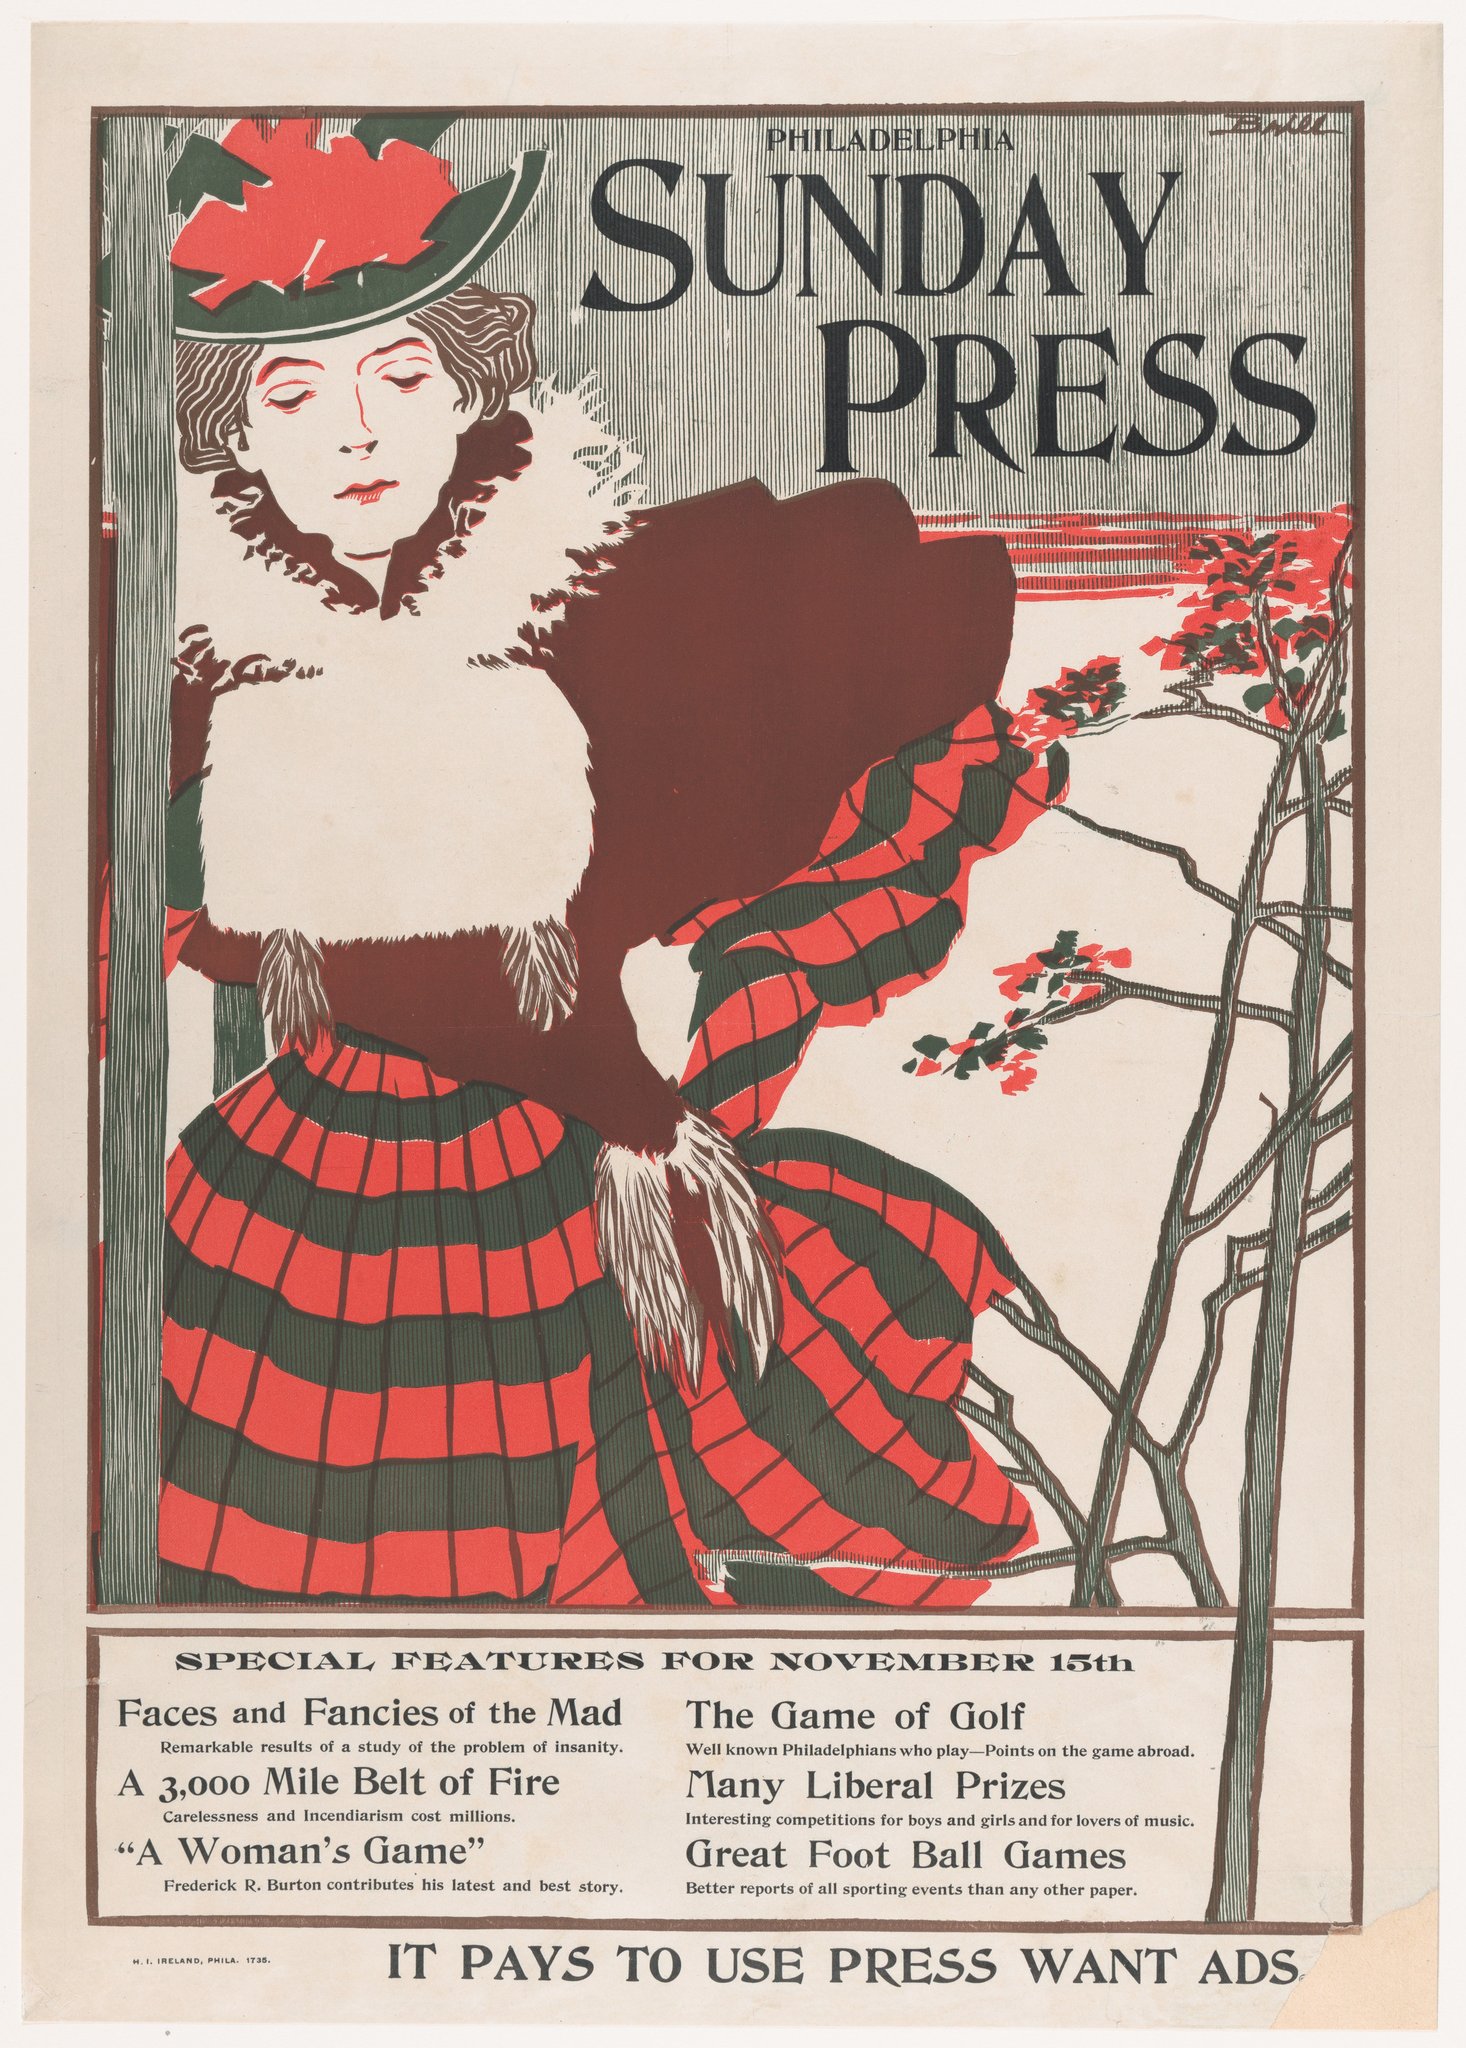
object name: print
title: Philadelphia Sunday Press, November 15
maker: george reiter brill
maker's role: artist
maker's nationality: american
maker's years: 1867-1918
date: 1851-1900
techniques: lithograph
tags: women